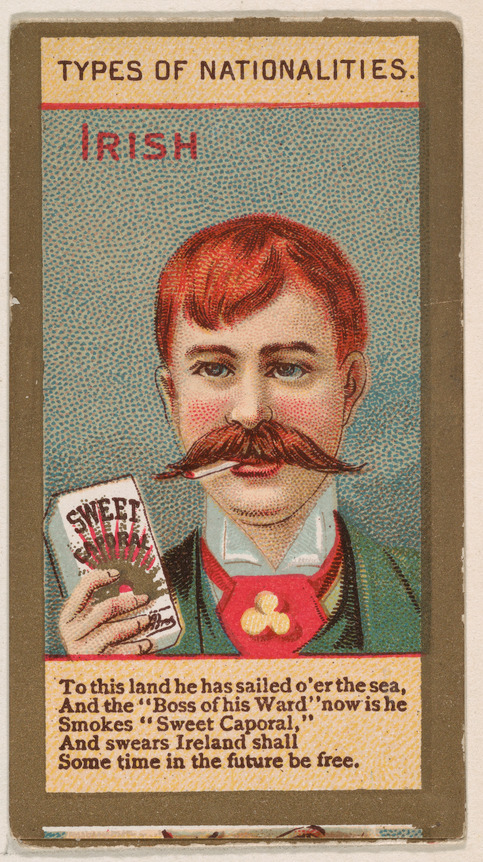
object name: print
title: Irish, from Types of Nationalities (N240) issued by Kinney Bros.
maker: kinney brothers tobacco company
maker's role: publisher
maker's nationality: american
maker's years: 1869-2011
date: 1890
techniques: color lithograph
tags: men